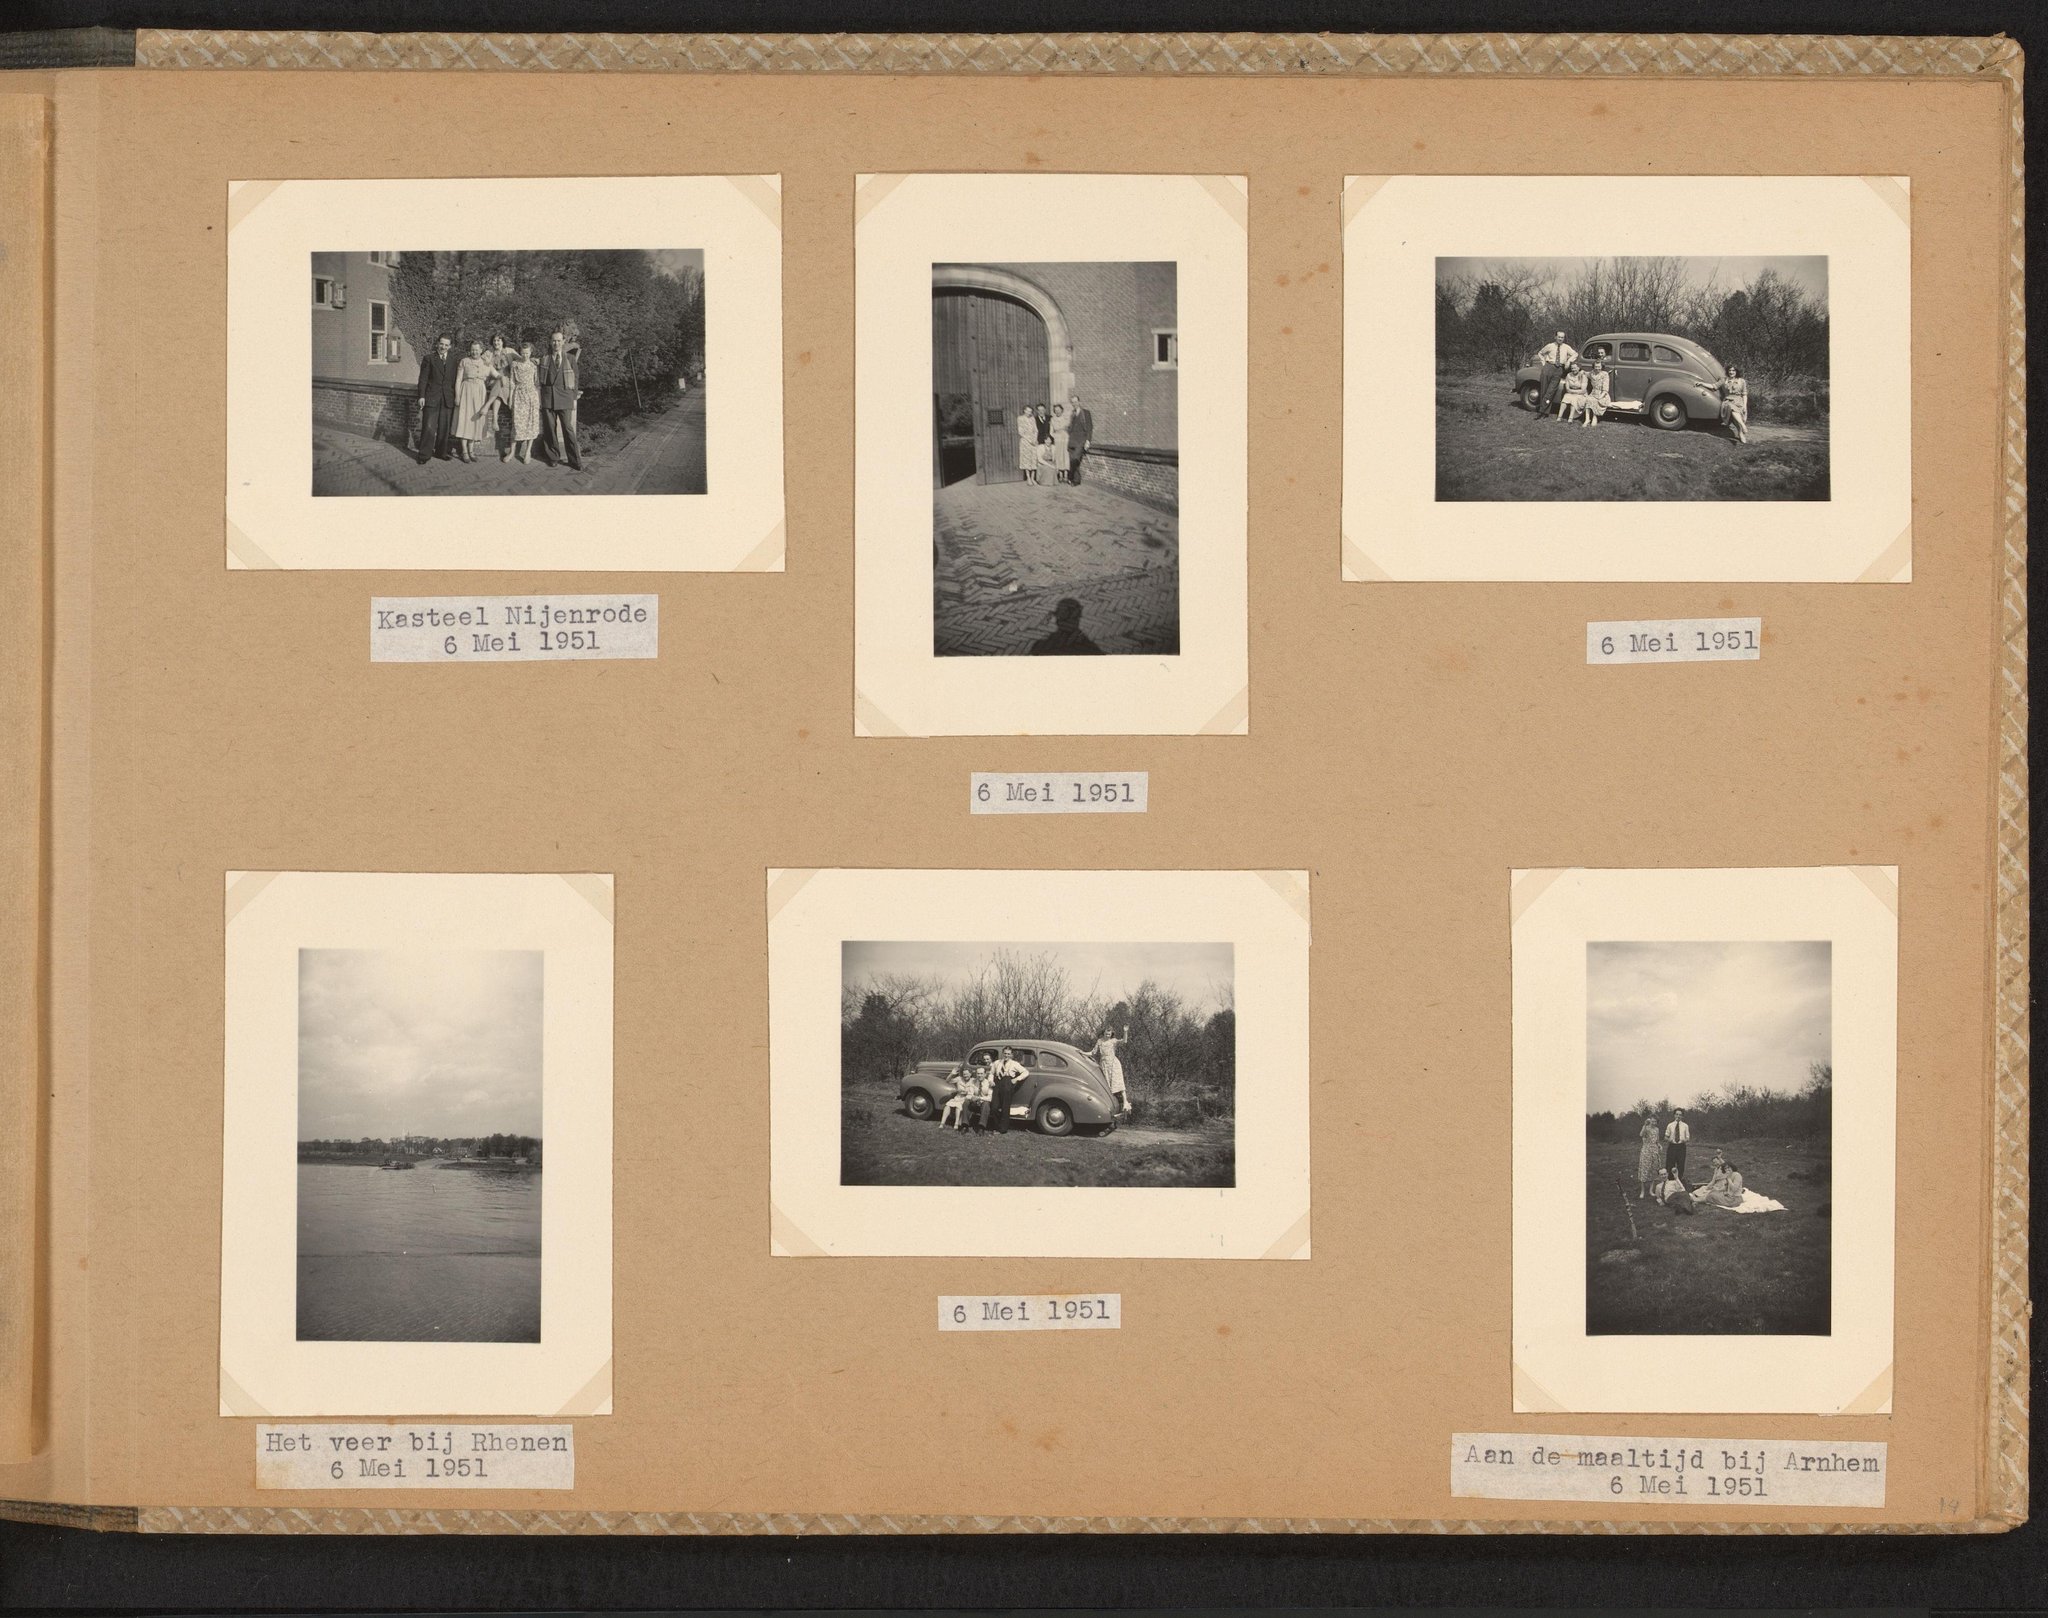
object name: album leaf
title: Dagtocht op 6 mei 1951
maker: Anonymous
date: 1951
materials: paper, photographic support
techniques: gelatin silver print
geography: belgium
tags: the family travelling, on holiday, outing, pleasure trip, rhenen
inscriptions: inscription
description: Albumblad met zes foto's van een dagtocht op 6 mei 1951 met de auto langs Kasteel Nijenrode, Rhenen en Arnhem. Onder de foto's uitgeknipte papiertjes met getypte opschriften. Onderdeel van het tweede fotoalbum met foto's van familievakanties in Nederland, België, Luxemburg en Frankrijk in 1950-1951.